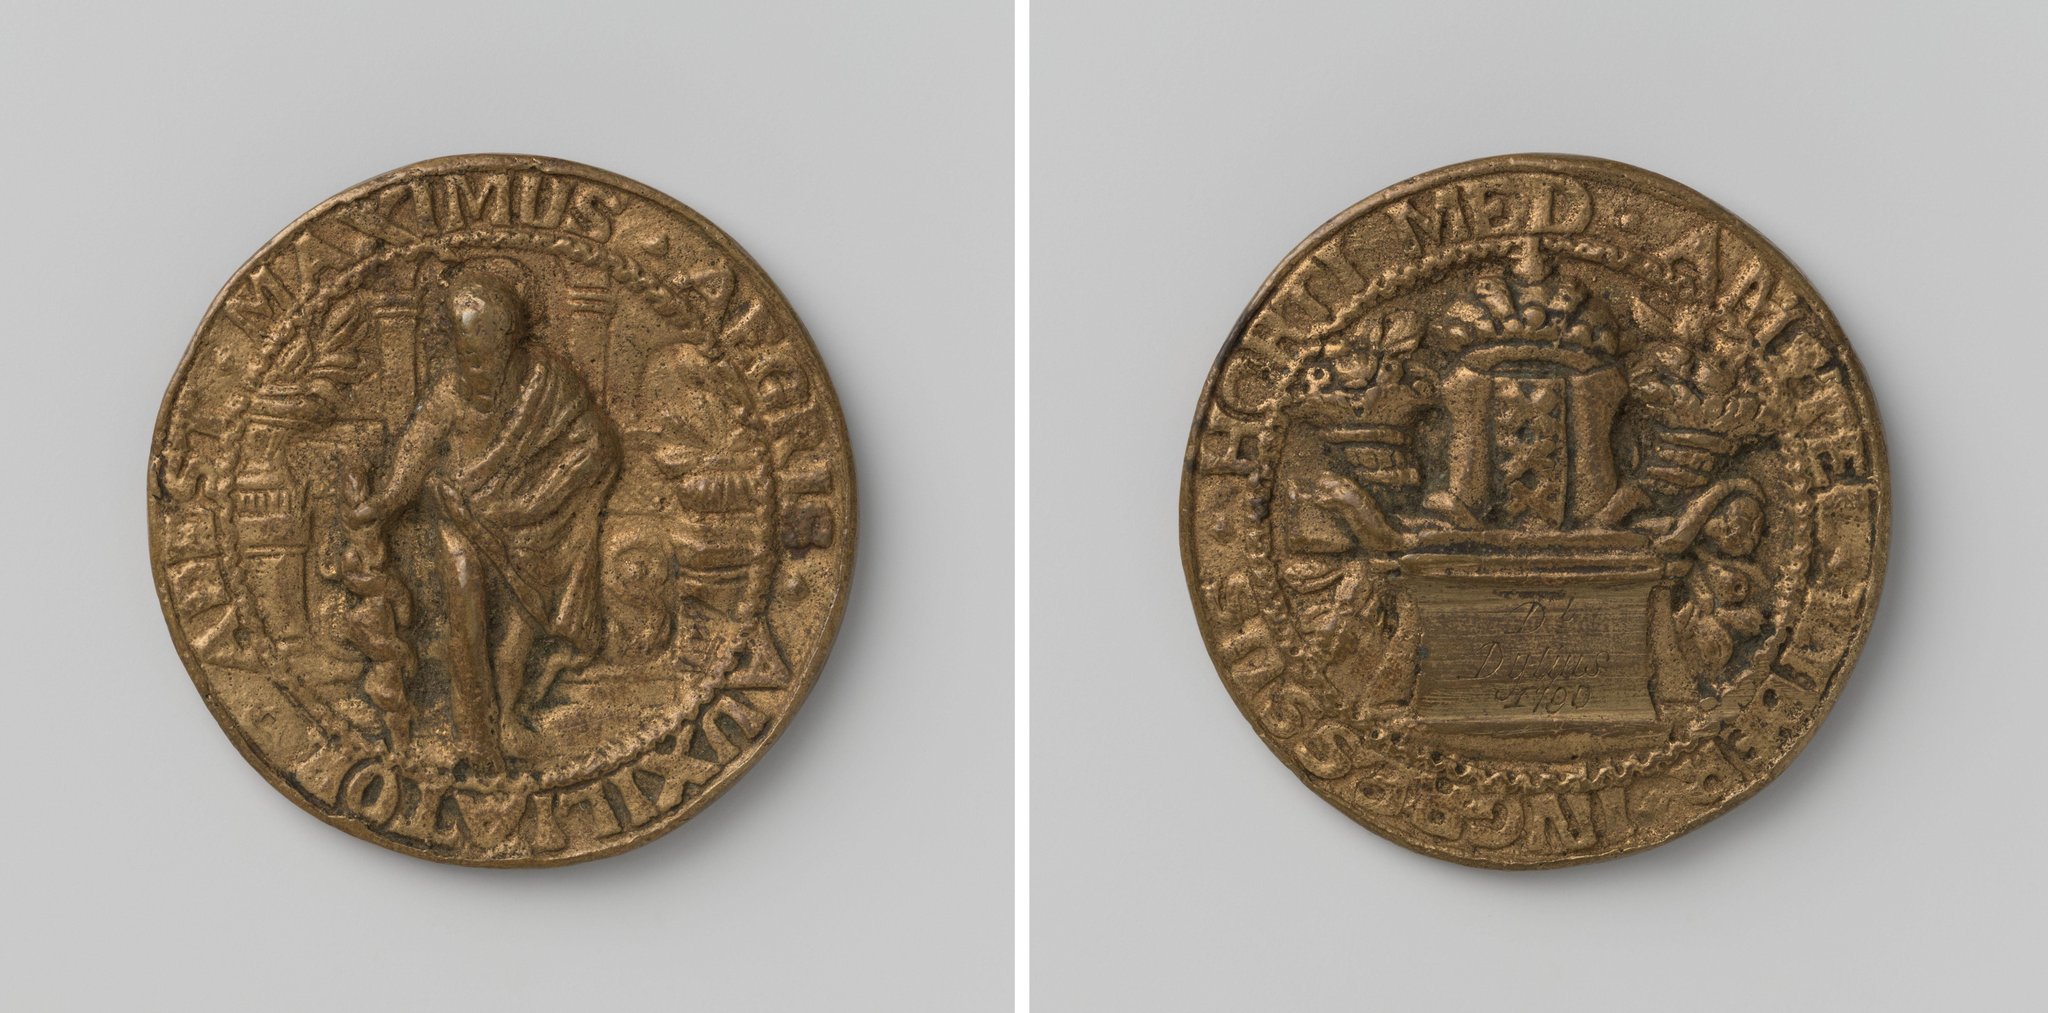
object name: toegangspenning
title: Collegium Medicum te Amsterdam, toegangspenning voor de hortus medicus van Daniel Dylius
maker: willem de wijs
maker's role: medailleur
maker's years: 1700-1795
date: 1790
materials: brass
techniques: casting, engraving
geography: amsterdam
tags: amsterdam, utrecht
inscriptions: inscription: ‘D.l Dylius 1790’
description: Messing penning. Voorzijde: Aesculapius met rechterhand leunend op slangestaf en linkerhand onder zijn mantel, staande tussen twee vazen met planten op voetstuk; op achtergrond wand van gebouw binnen omschrift. Keerzijde: gekroond wapenschild tussen twee gevulde hoorns van overvloed boven zalfspatel, waarom slang zich kronkelt, liggend op voetstuk met opschrift binnen omschrift